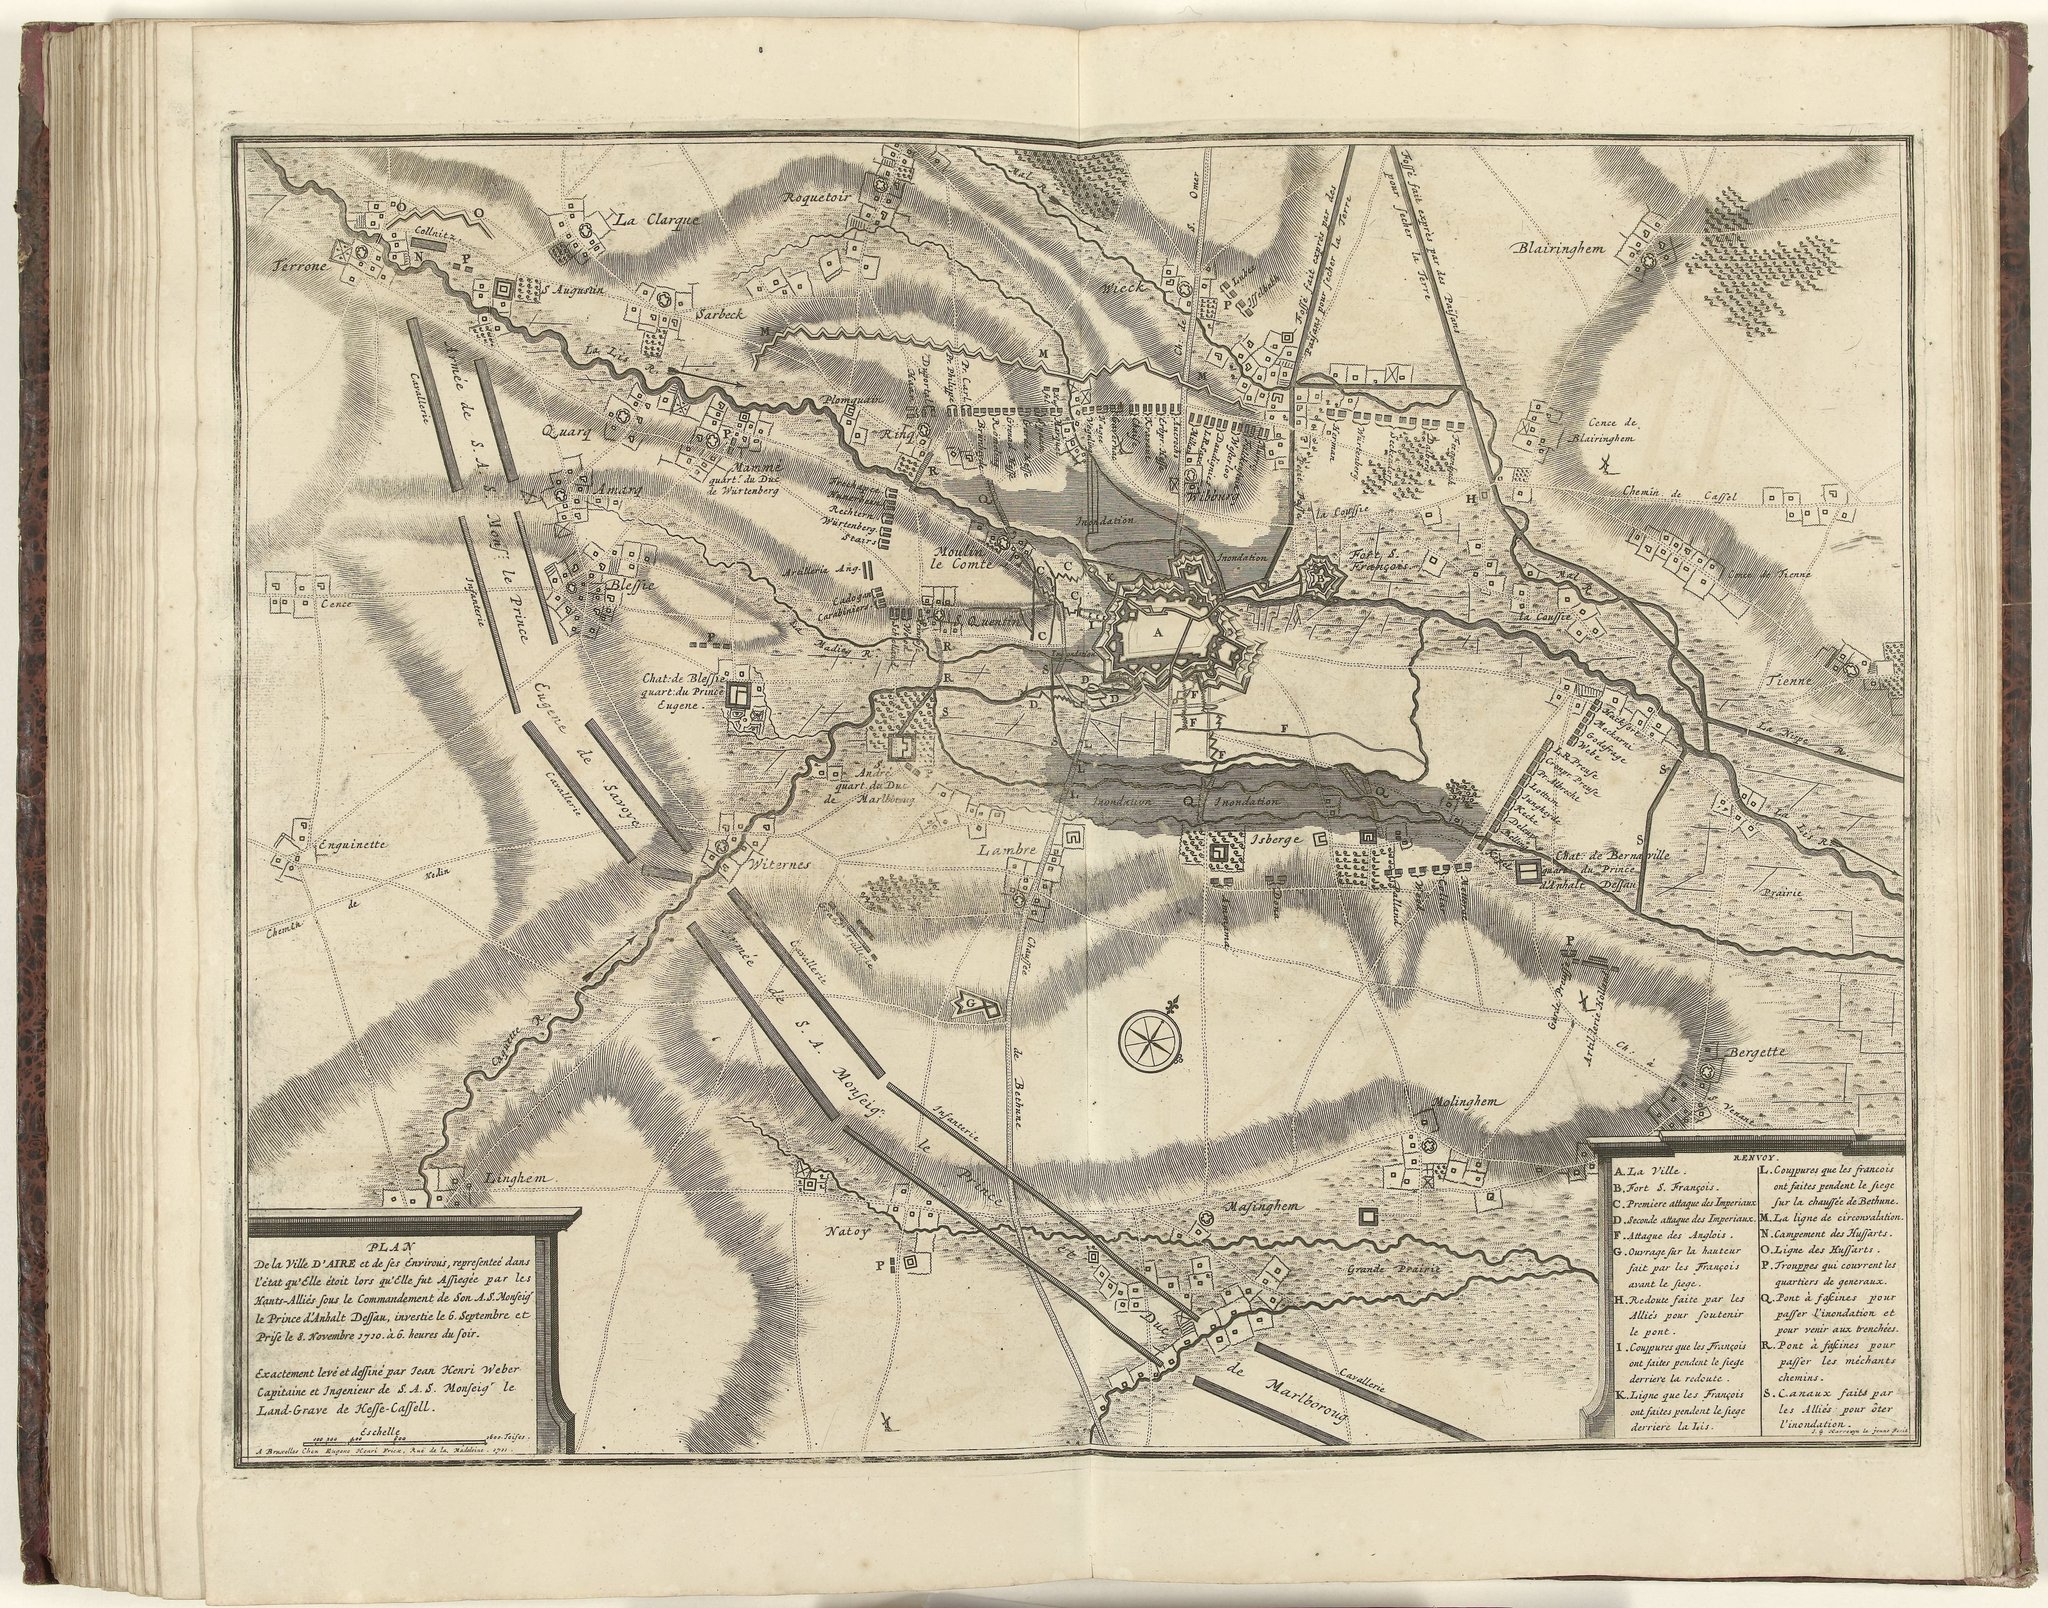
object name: map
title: Beleg van Aire, 1710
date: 1711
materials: paper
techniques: engraving, etching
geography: brussels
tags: maps of separate countries or regions, siege, position war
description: Kaart van het beleg van de stad Aire met de wijde omgeving, belegerd vanaf 11 september en ingenomen door de Geallieerden onder de vorst van Anhalt-Dessau op 8 november 1710. Rechtsonder een cartouche met de legenda A-S in het Frans. Onderdeel van een gebundelde verzameling van plannen van veldslagen en steden vermaard in de Spaanse Successieoorlog.